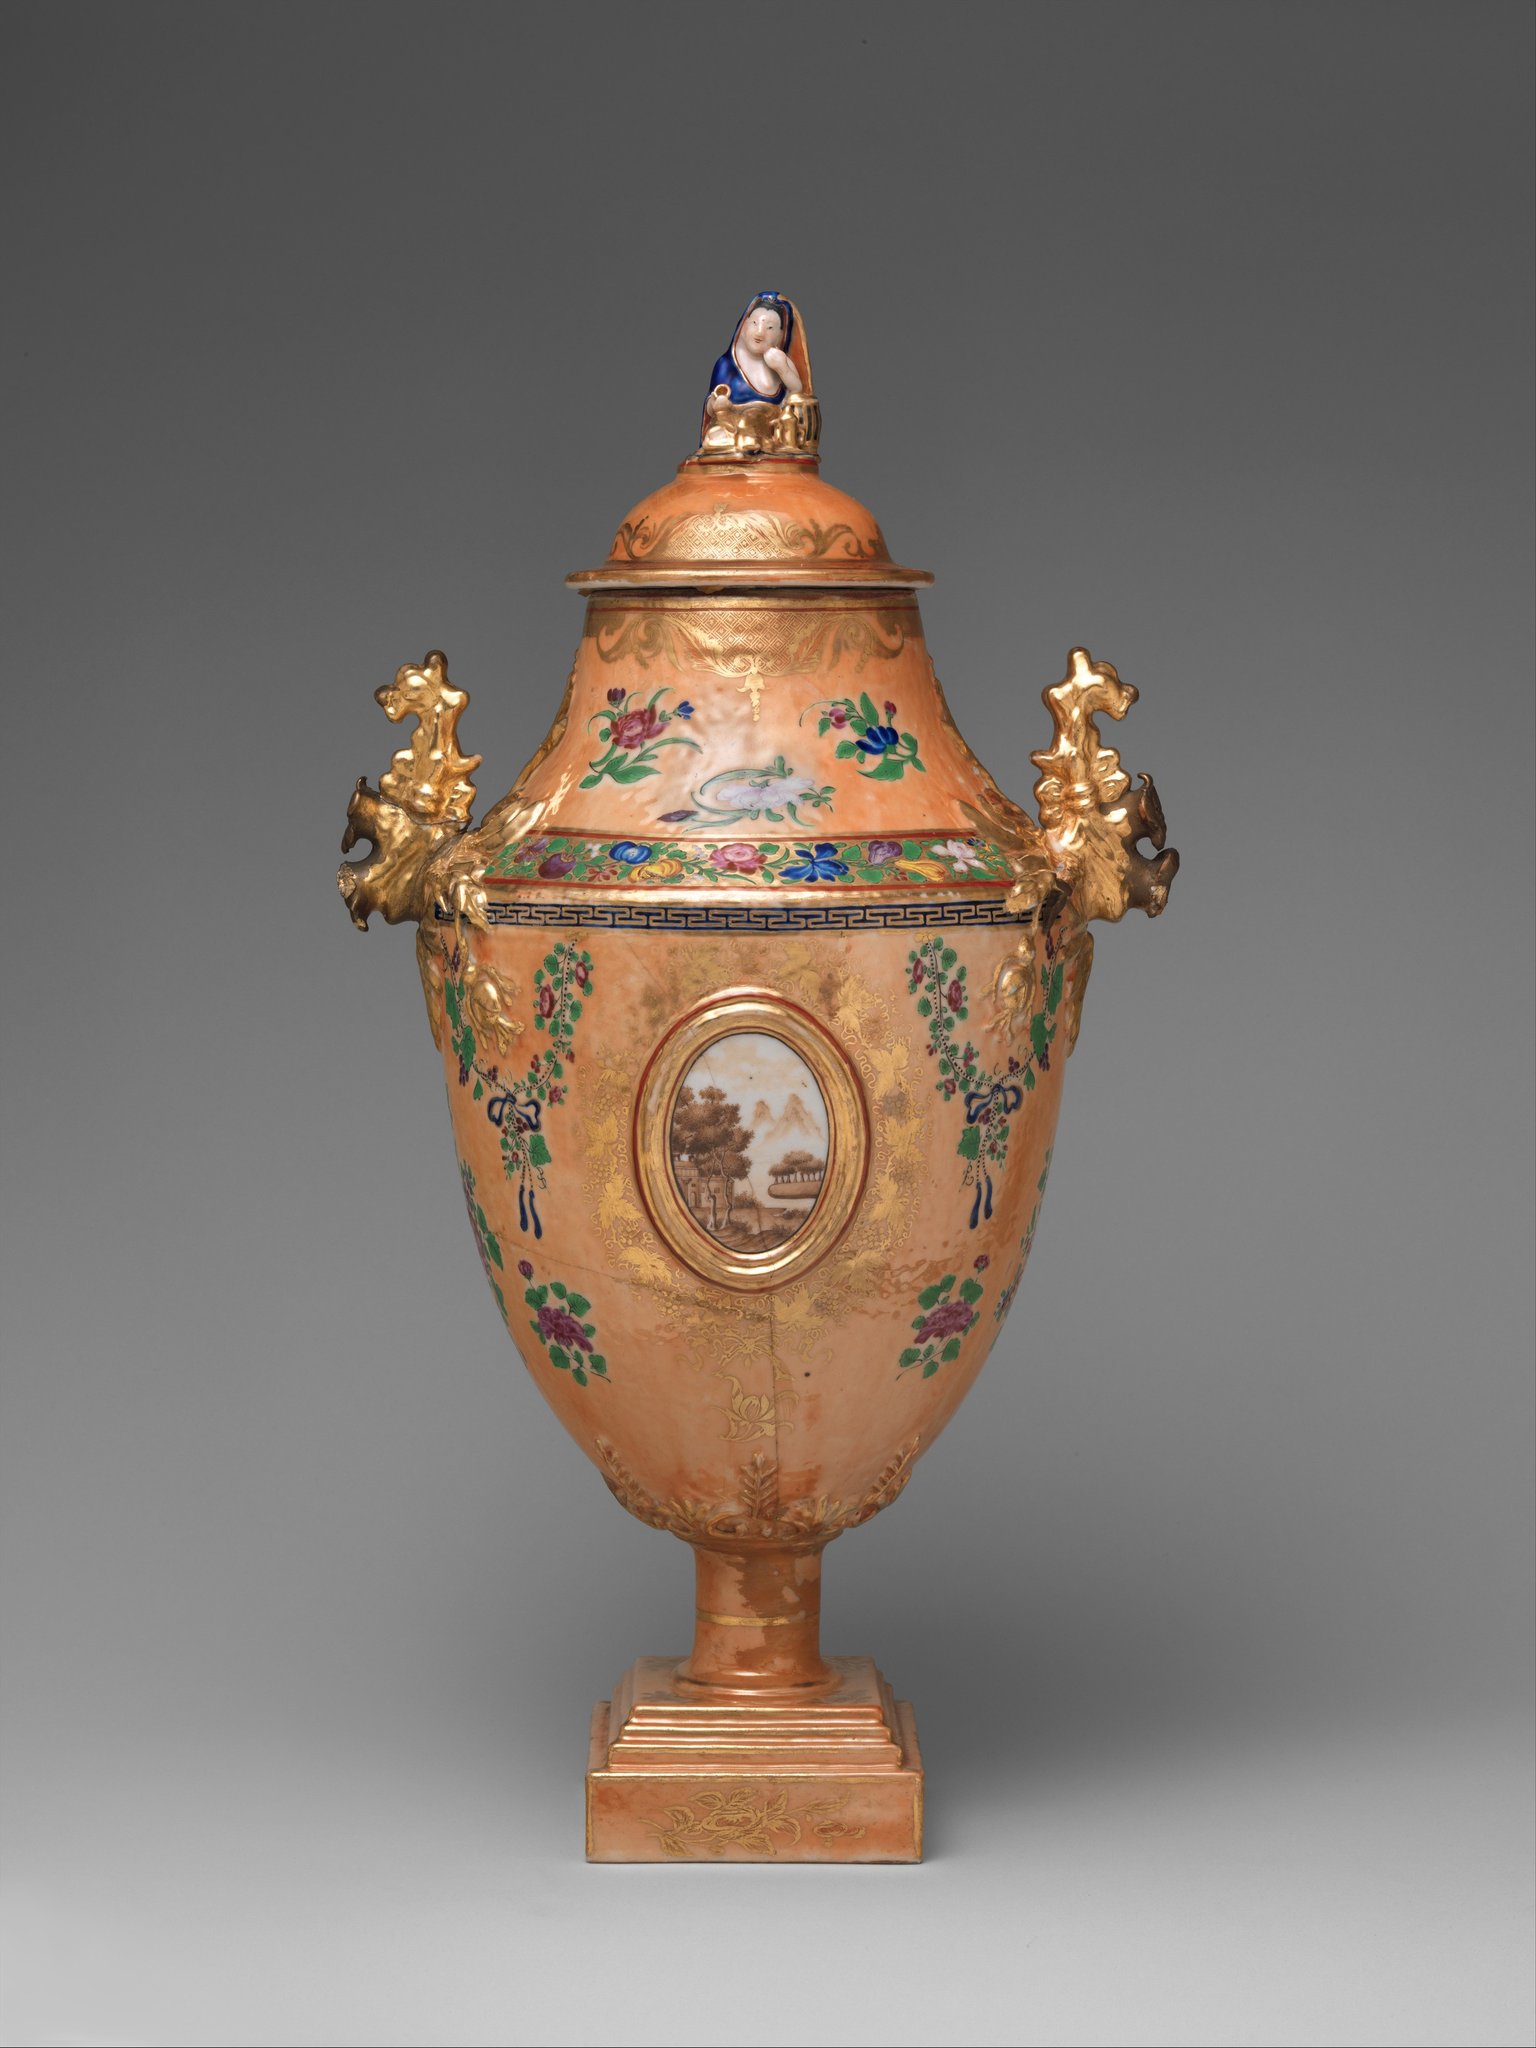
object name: vase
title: Covered Vase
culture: chinese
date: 1736-1795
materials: porcelain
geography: china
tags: flowers,landscapes